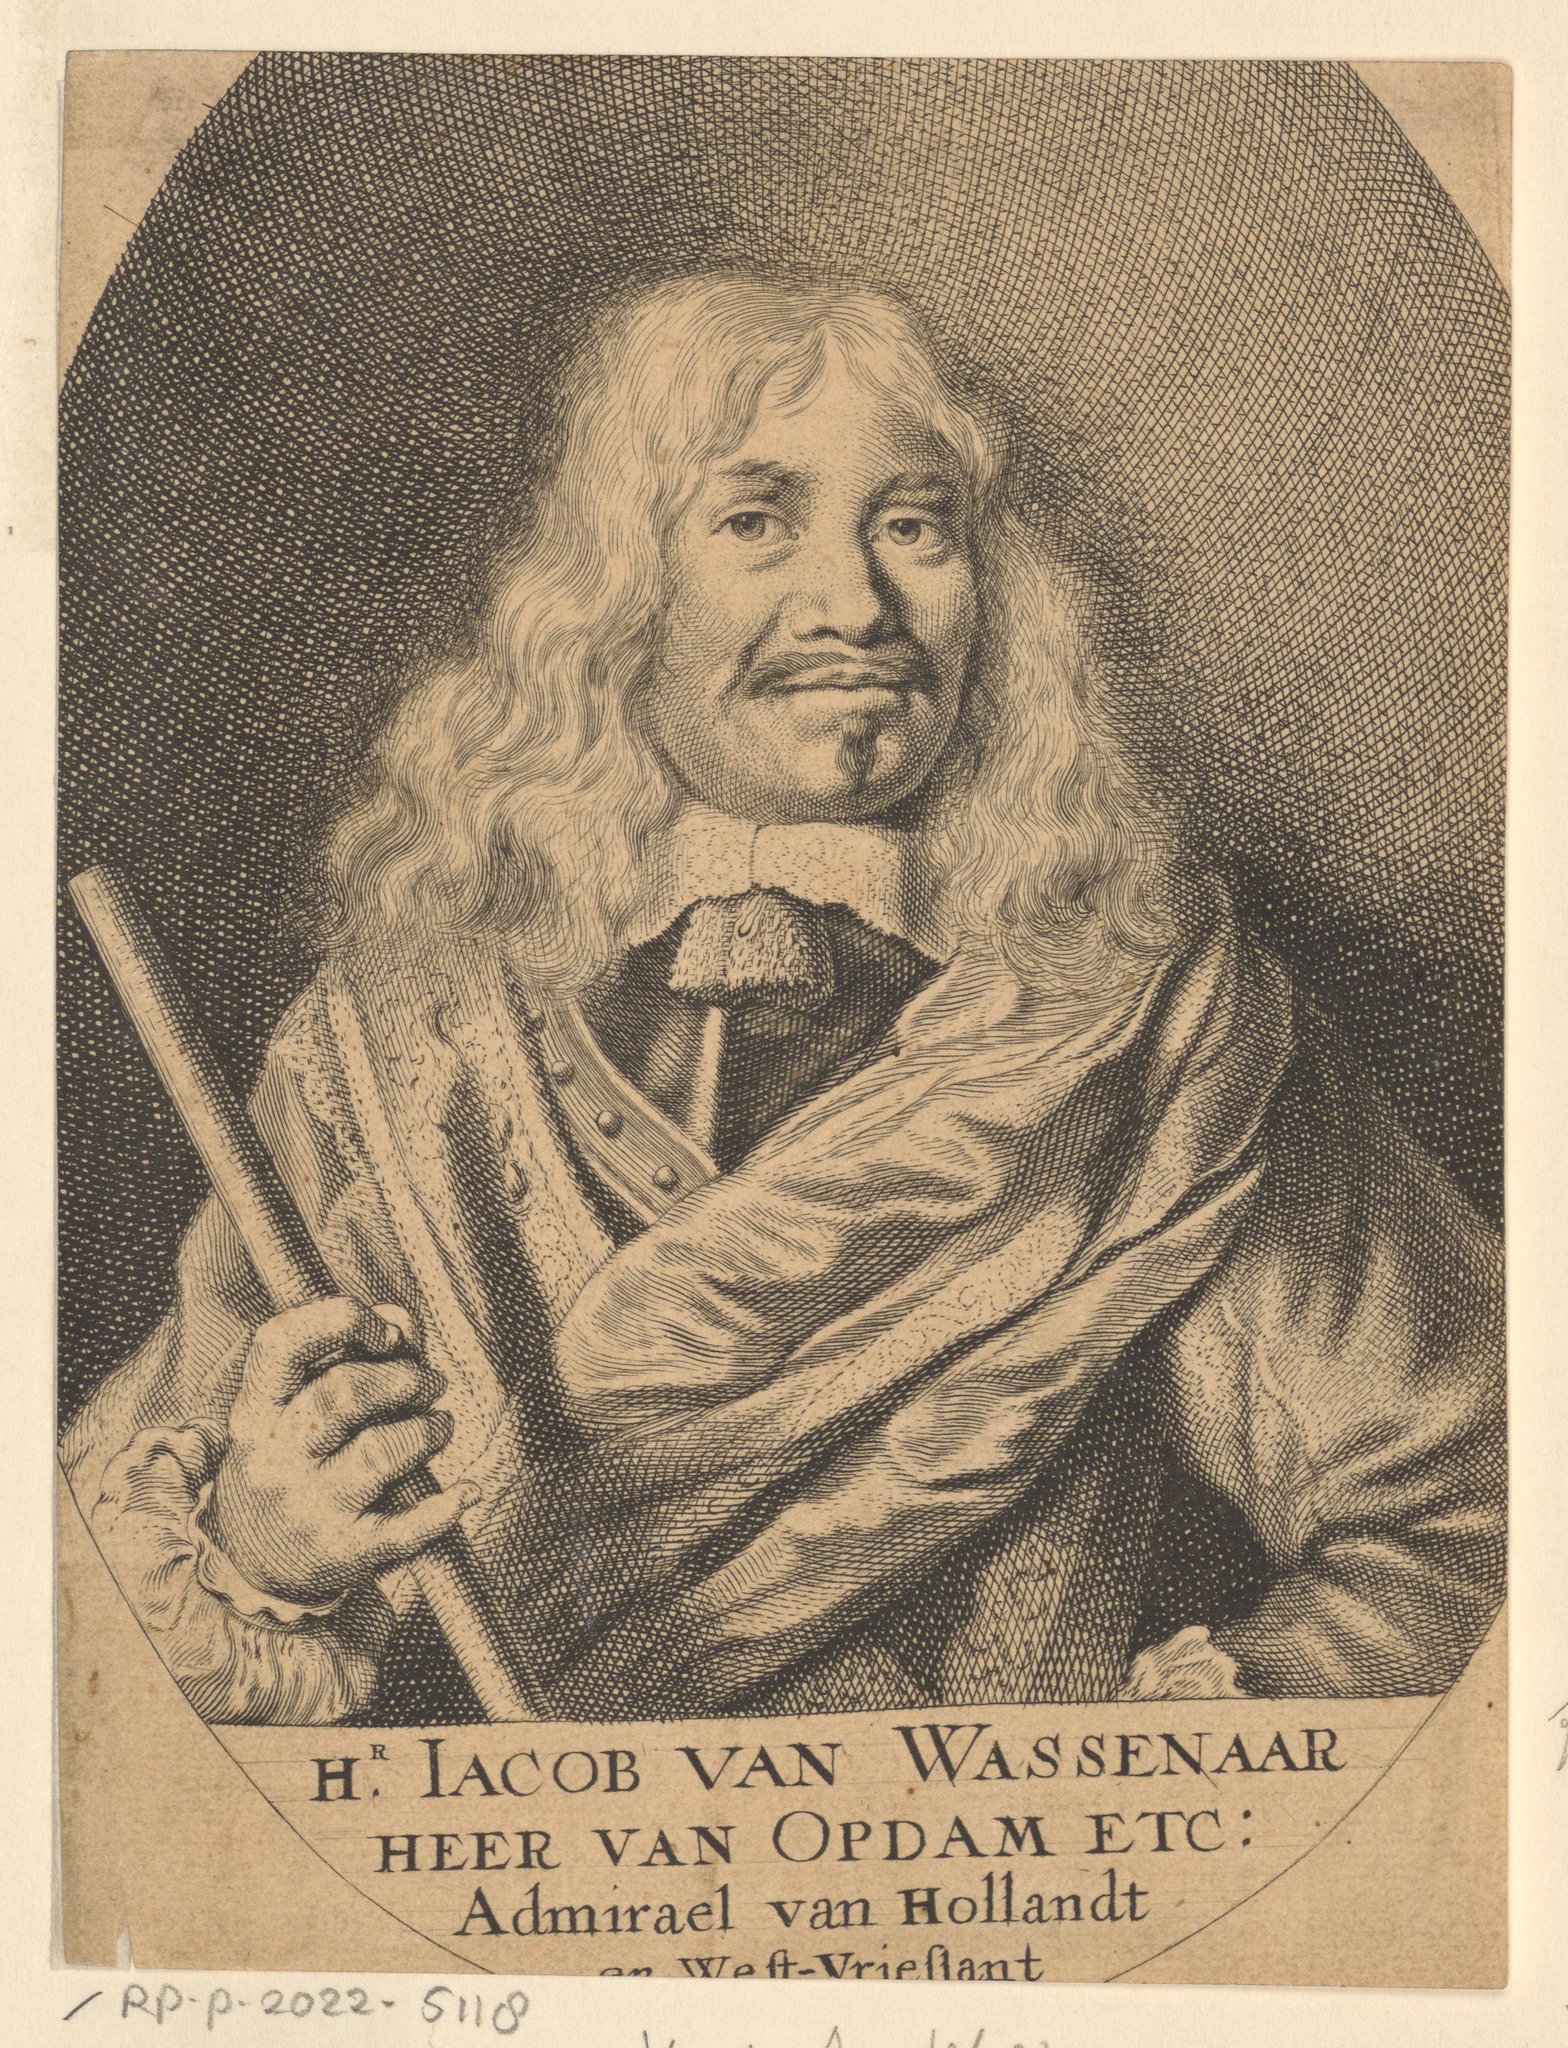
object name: print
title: Portret van Jacob, baron van Wassenaer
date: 1640-1653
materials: paper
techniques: engraving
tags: jacob baron van wassenaer heer van obdam, historical persons, baton of general, commander-in-chief, admiral